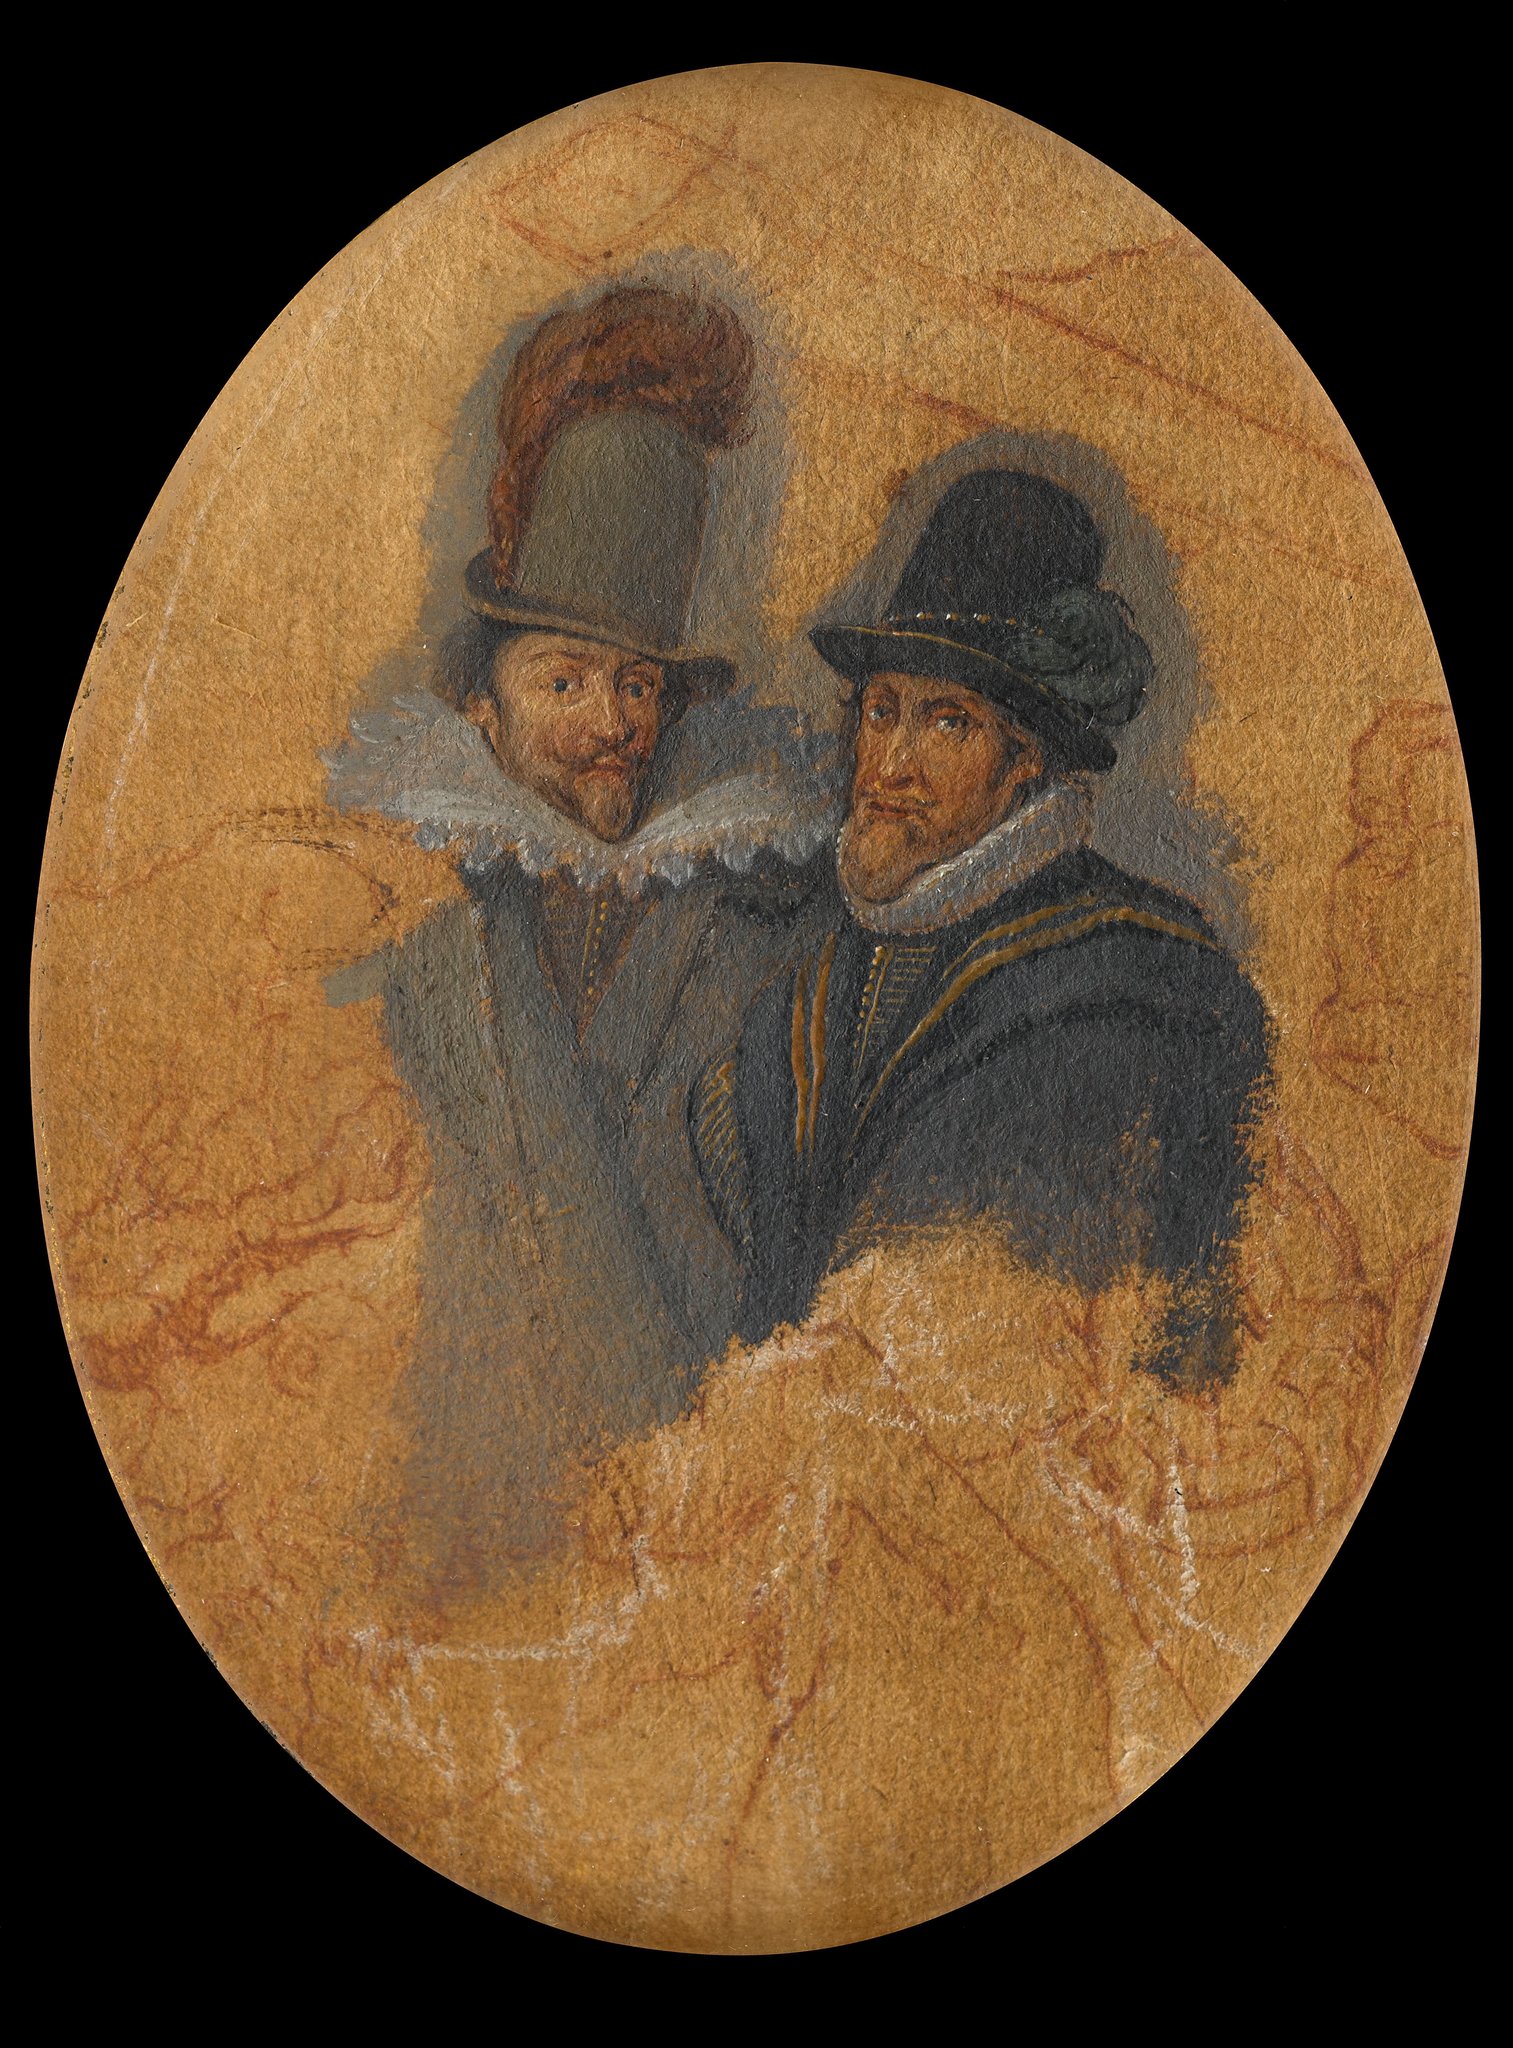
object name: drawing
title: Portrait of Princes Maurits (1567-1625) and Frederik Hendrik (1584-1647)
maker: adriaen pietersz van de venne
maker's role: draughtsman, painter, print maker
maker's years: 1589-1662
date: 1615-1625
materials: glass, oil, paper, wood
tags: frederick henry (prince of orange), maurice (prince of orange), historical persons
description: Portretten van de prinsen Maurits (1567-1625) en Frederik Hendrik (1584-1647), ten halven lijve, onvoltooid werk.